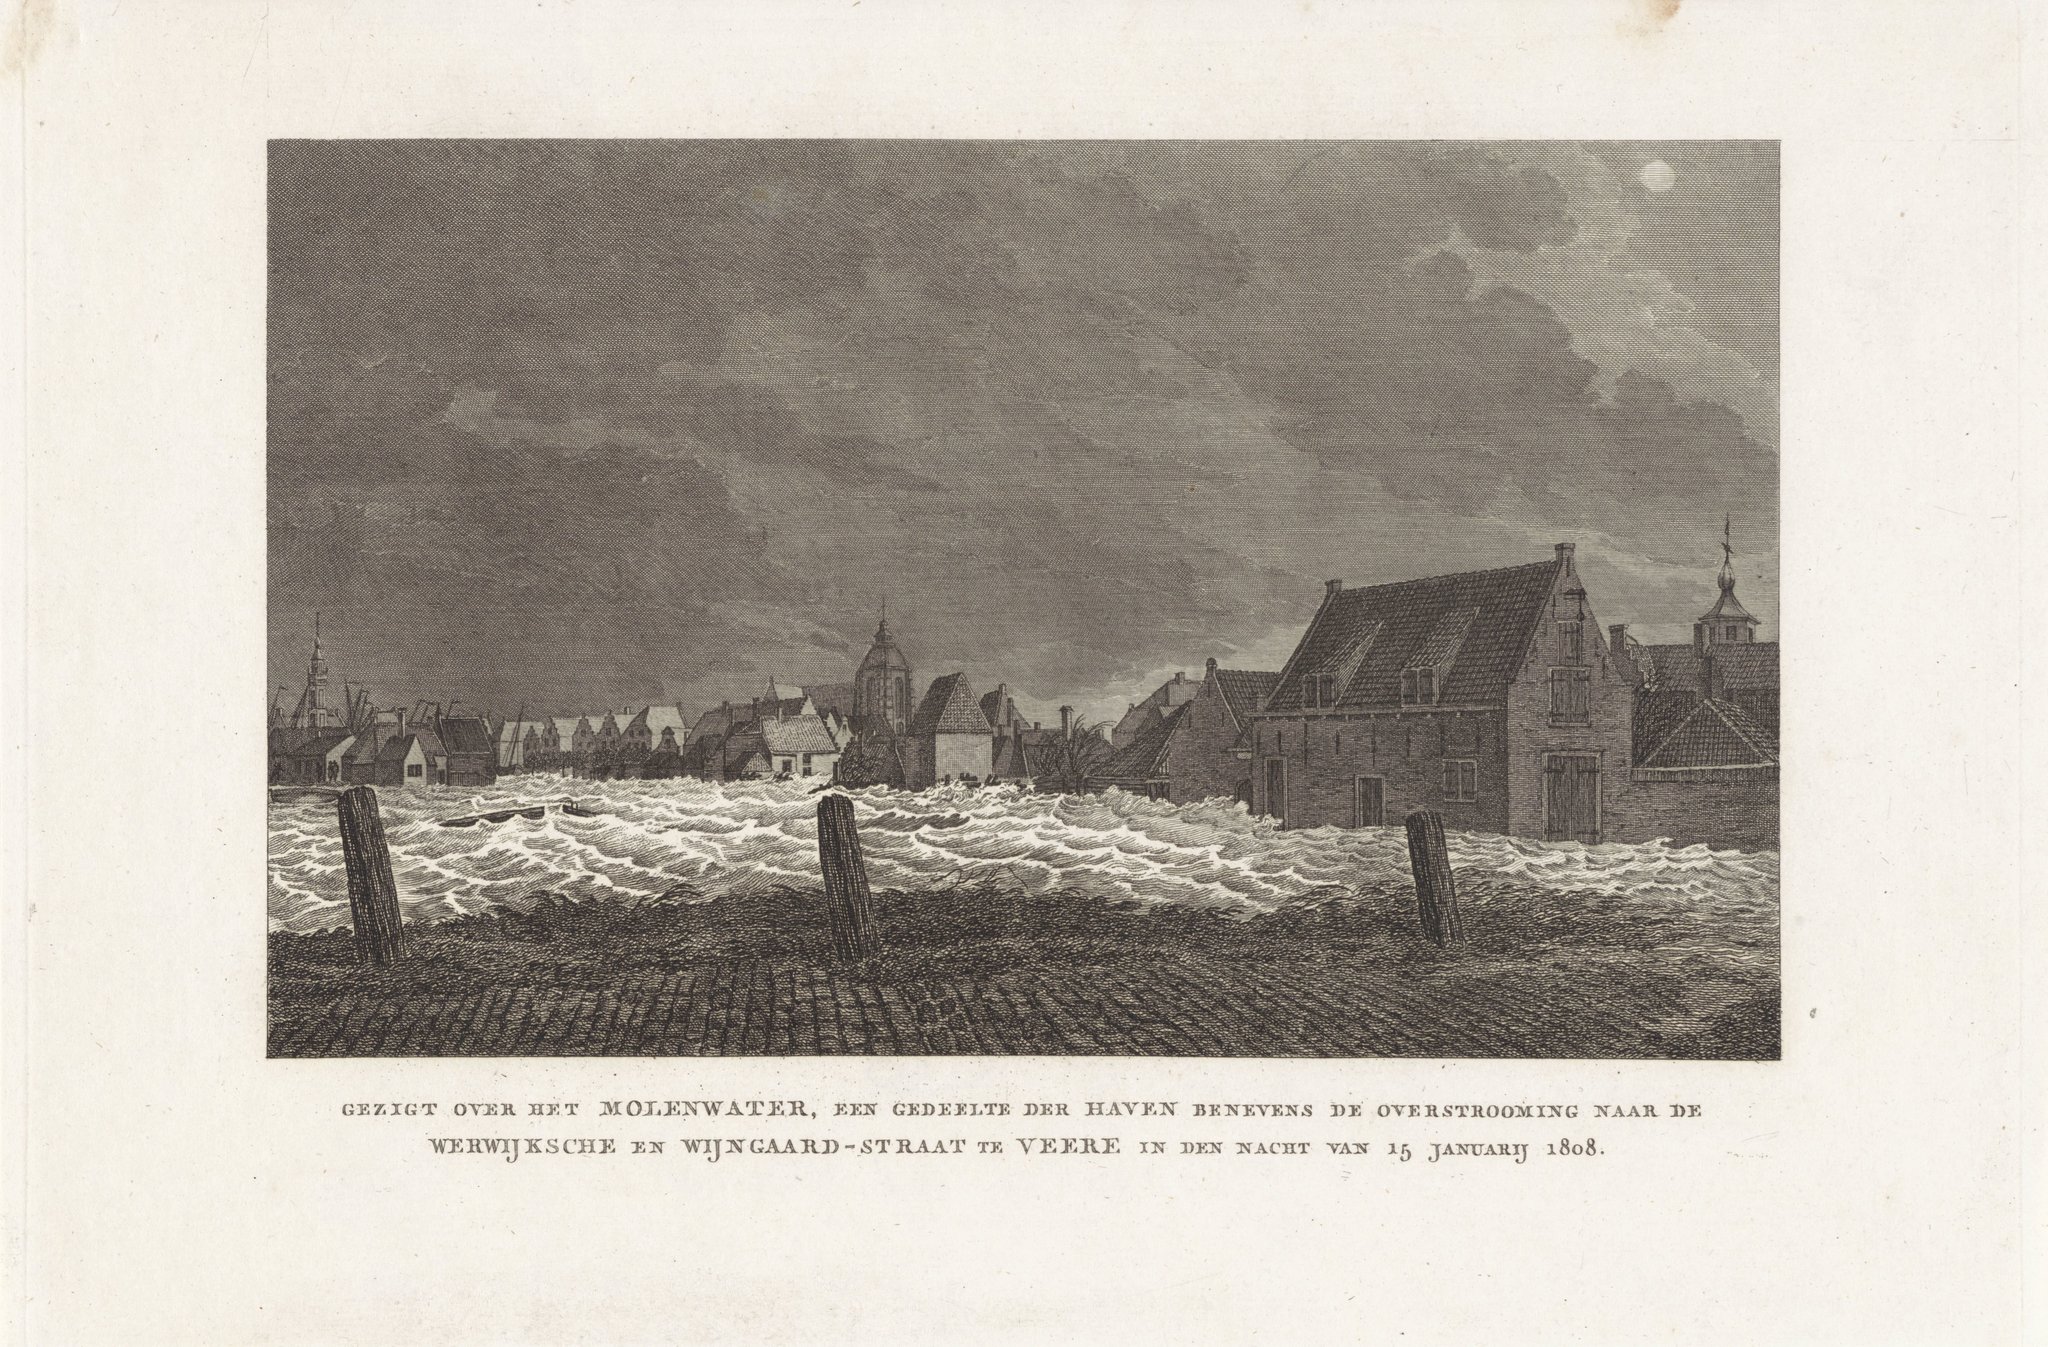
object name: print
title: Overstroming bij het Molenwater en de haven te Veere, 1808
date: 1808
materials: paper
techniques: etching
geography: haarlem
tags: flood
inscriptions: collector's mark: Lugt Lugt 2228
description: Prent gebruikt in: Hoek, S. van. Natuur- en geschiedkundige beschrijving van den verschrikkelijken watervloed tusschen den XIVden en XVden van Louwmaand des jaars 1808. Haarlem: Adriaan Pietersz. Loosjes, 1808.